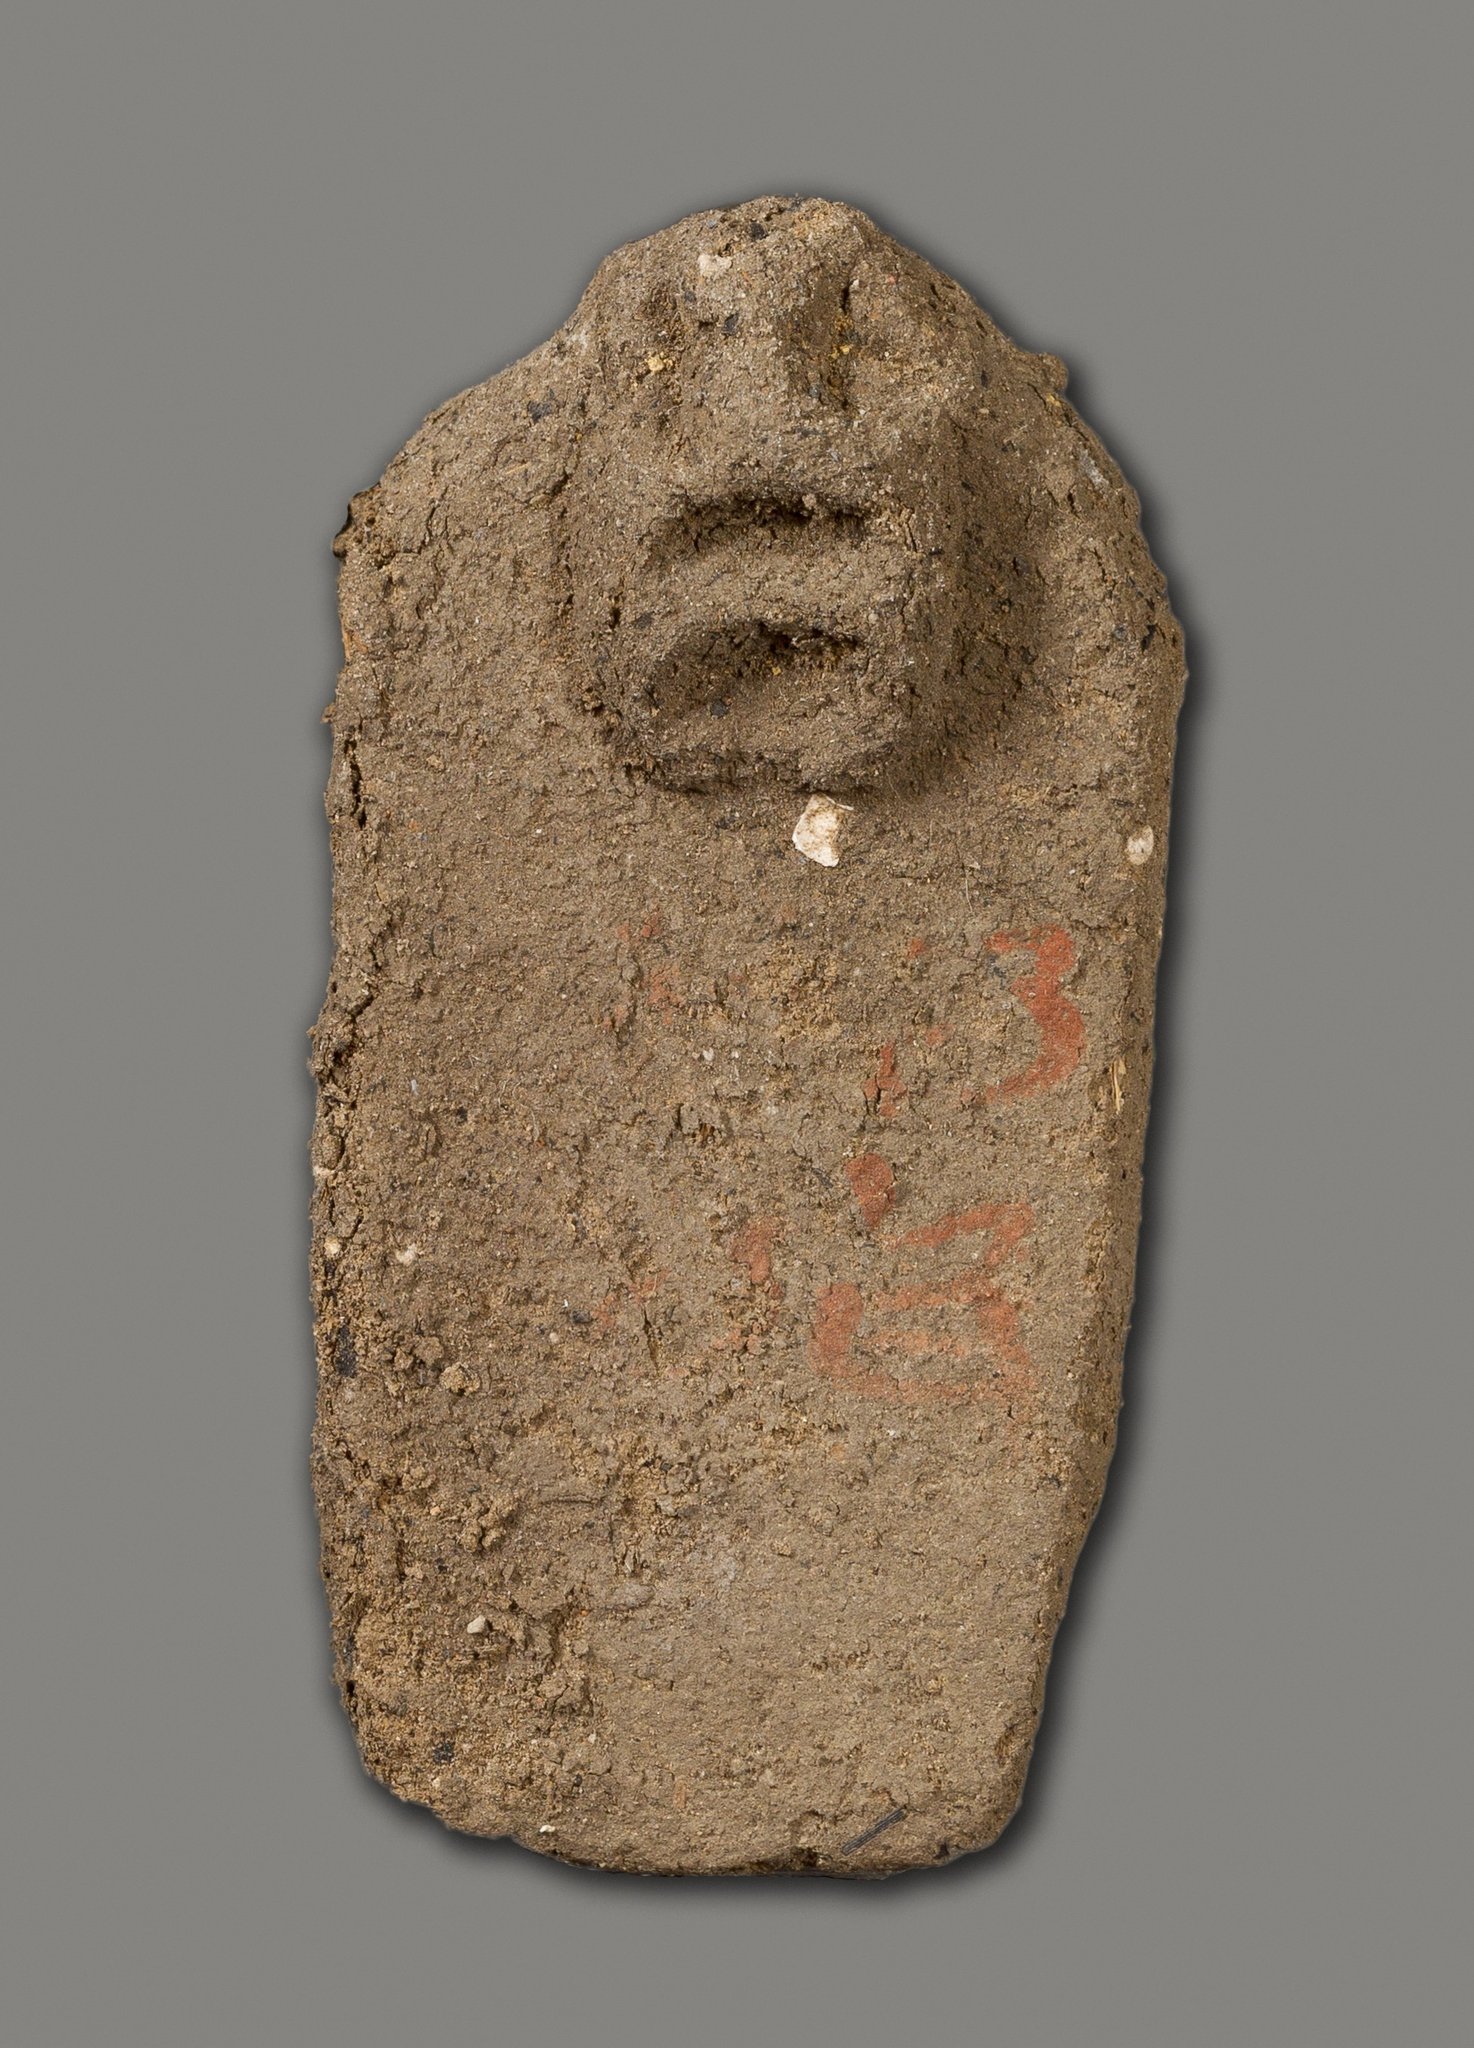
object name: figure, magical, execration, tablet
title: Magical Figure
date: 1802-1550 BCE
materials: clay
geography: egypt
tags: faces